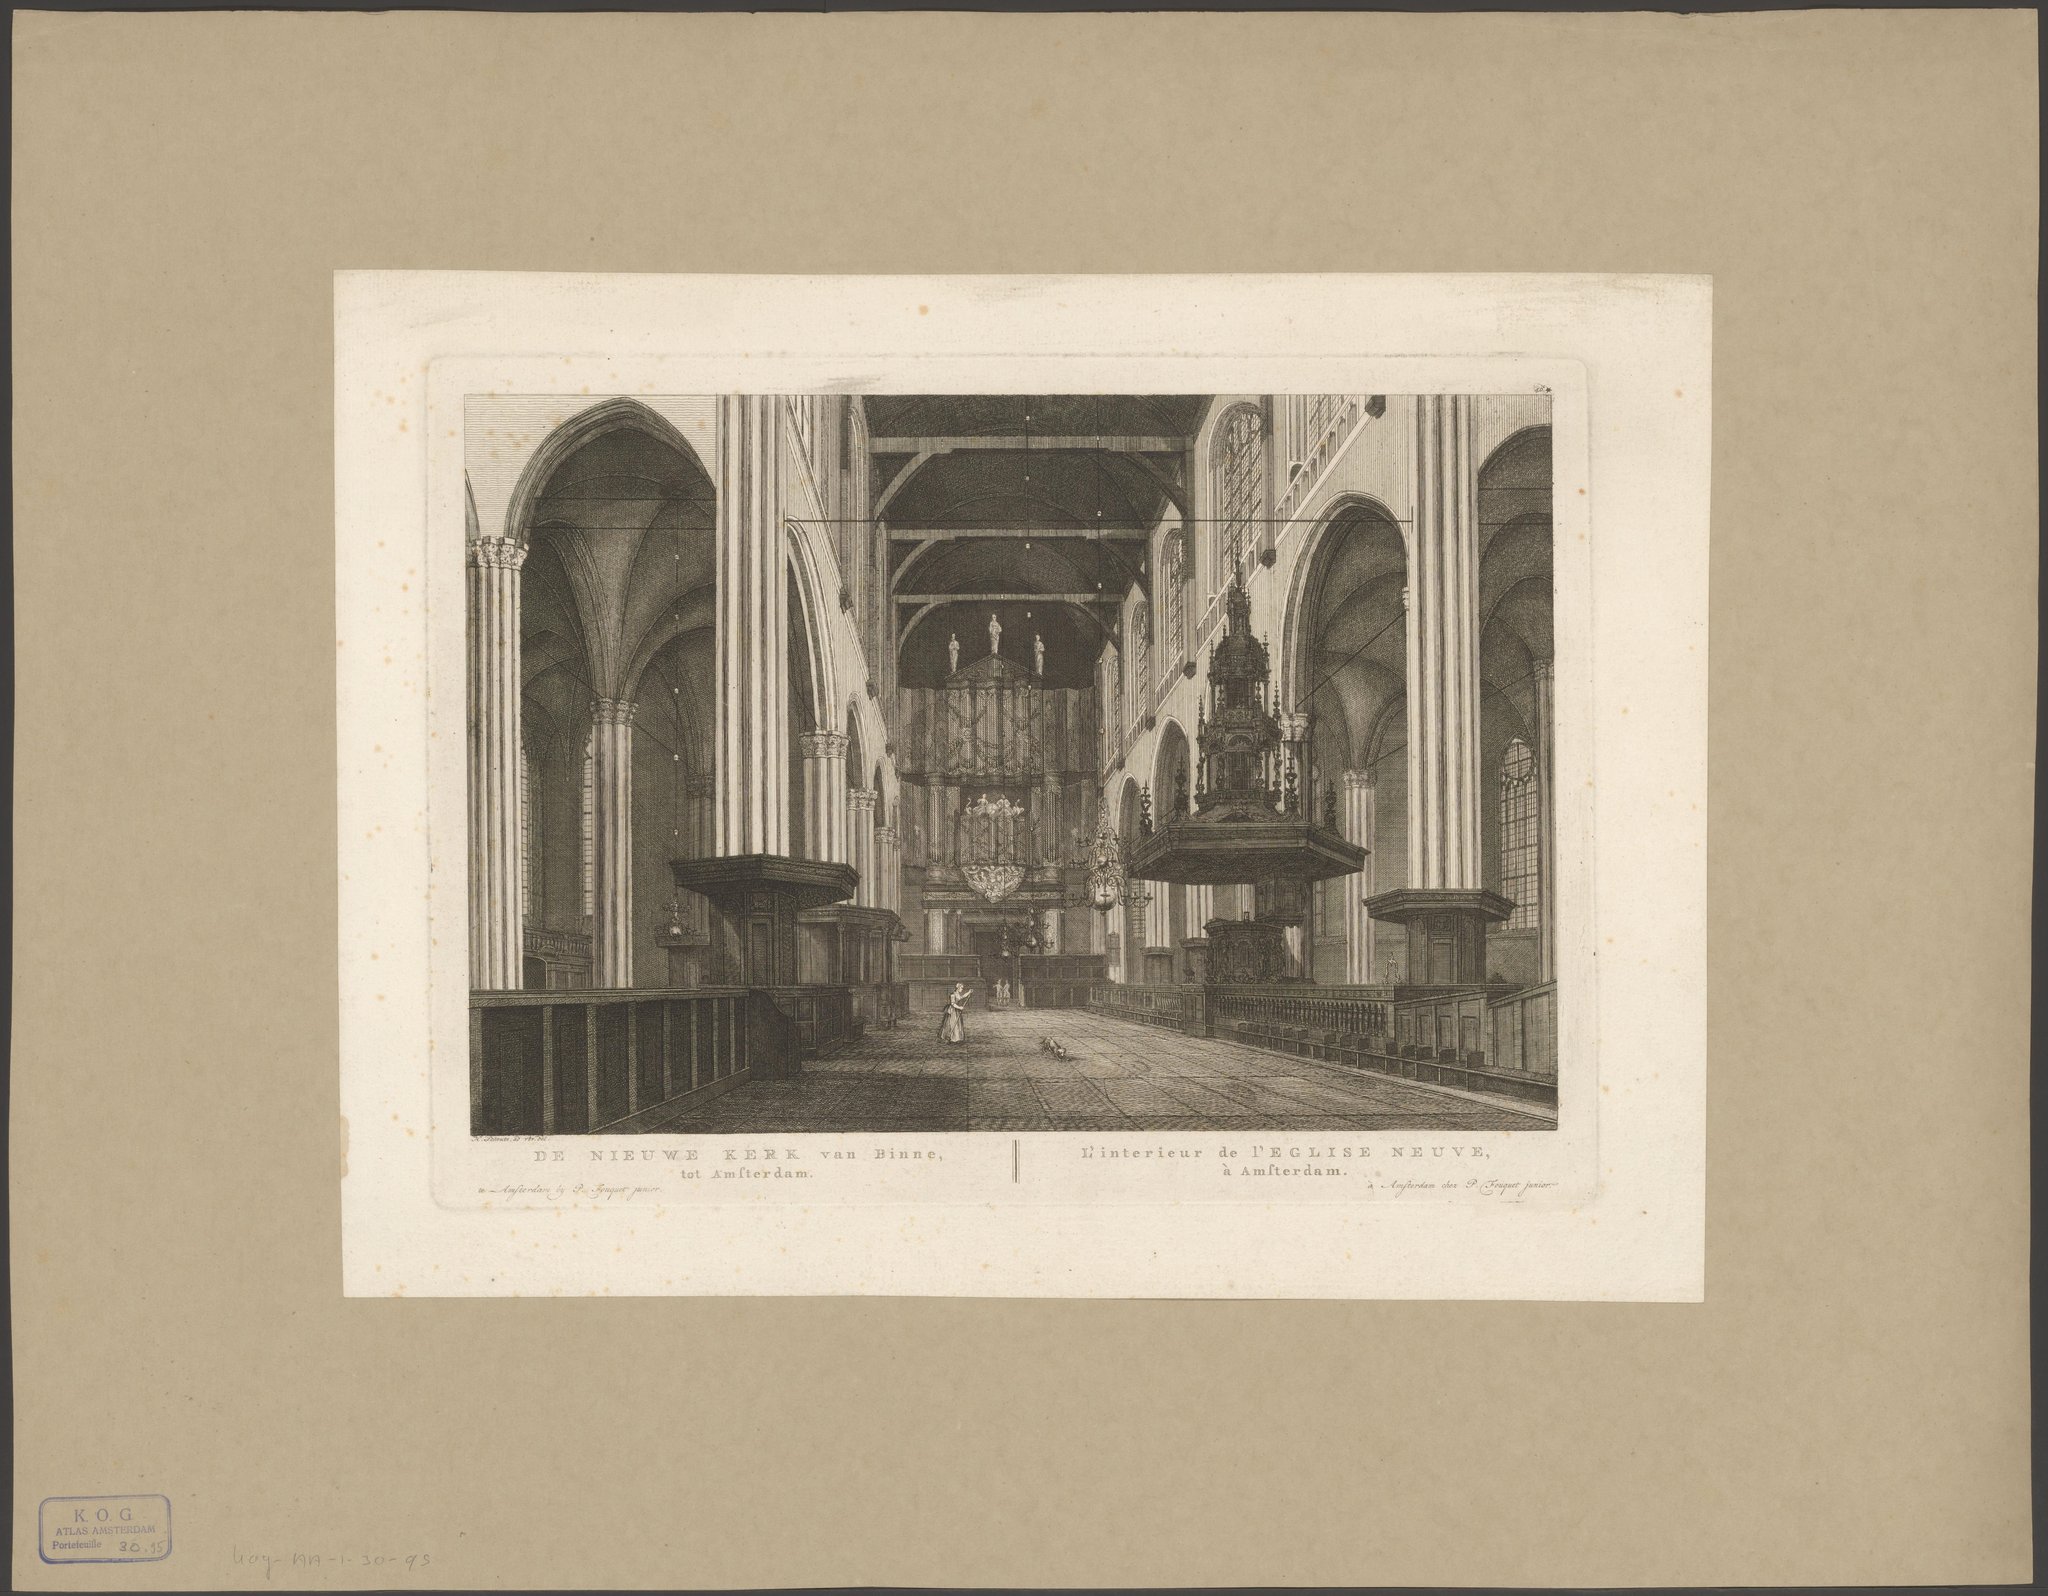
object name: print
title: De Nieuwe Kerk van Binne, tot Amsterdam / L'interieur de l'Eglise Neuve, à Amsterdam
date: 1770-1783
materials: paper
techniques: engraving, etching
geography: amsterdam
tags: interior of church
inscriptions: collector's mark: Lugt 1641b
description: Vanaf 1760 gaf Pierre Fouquet stadsgezichten van Amsterdam naar tekeningen van verschillende kunstenaars uit. Deze prenten werden aanvankelijk los verkocht. Later werden ze samengebonden verkocht in verschillende volgordes en aantallen in: (1). Afbeeldingen van de wyd-vermaarde koopstad Amsterdam benevens des zelvs voornaamste gebouwen en gezigten alle naar het leeven getekend / Receuil des edifices les plus considerables et des plus belles vues, de la fameuse ville d'Amsterdam, dessinées d'après nature. Amsterdam: Pierre Fouquet, 1778-1783. Deze 'uitgave' bestond waarschijnlijk alleen uit een titelblad en inhoudsopgave van de tot dusver 100 uitgegeven prenten, die de koper zelf aan zijn of haar reeds verzamelde prenten kon toevoegen. De hoeveelheid en volgorde van prenten verzameld onder deze titel verschilt dus sterk. (2). Nieuwe atlas, van de voornaamste gebouwen en gezigten der stad Amsterdam, met derzelver beknopte beschryvingen. 2 dln. Amsterdam: Daniël Jean Changuion en Petrus den Hengst [in opdracht van Pierre Fouquet], 1783. Ook werden er door verschillende uitgevers tussen 1788 (Amsterdam: Petrus Conradi) en 1805 (Amsterdam: Evert Maaskamp) heruitgaven gepubliceerd.